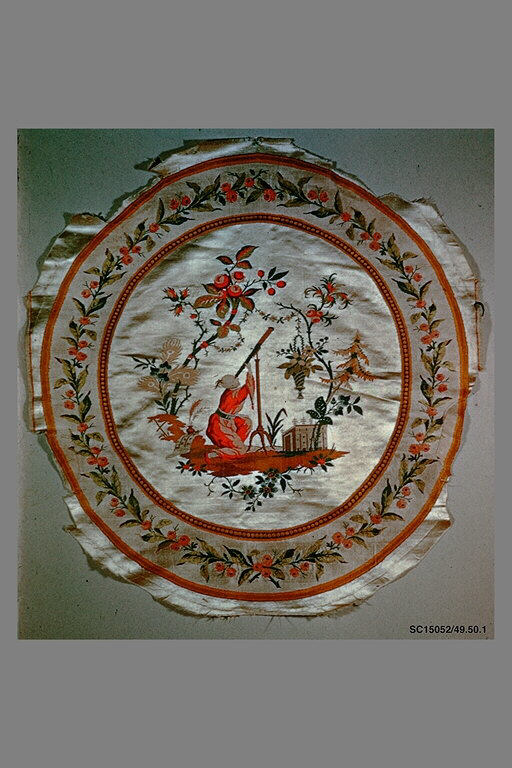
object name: upholstery panel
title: Chair seat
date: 1780-1790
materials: silk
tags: chinoiserie,men,telescopes